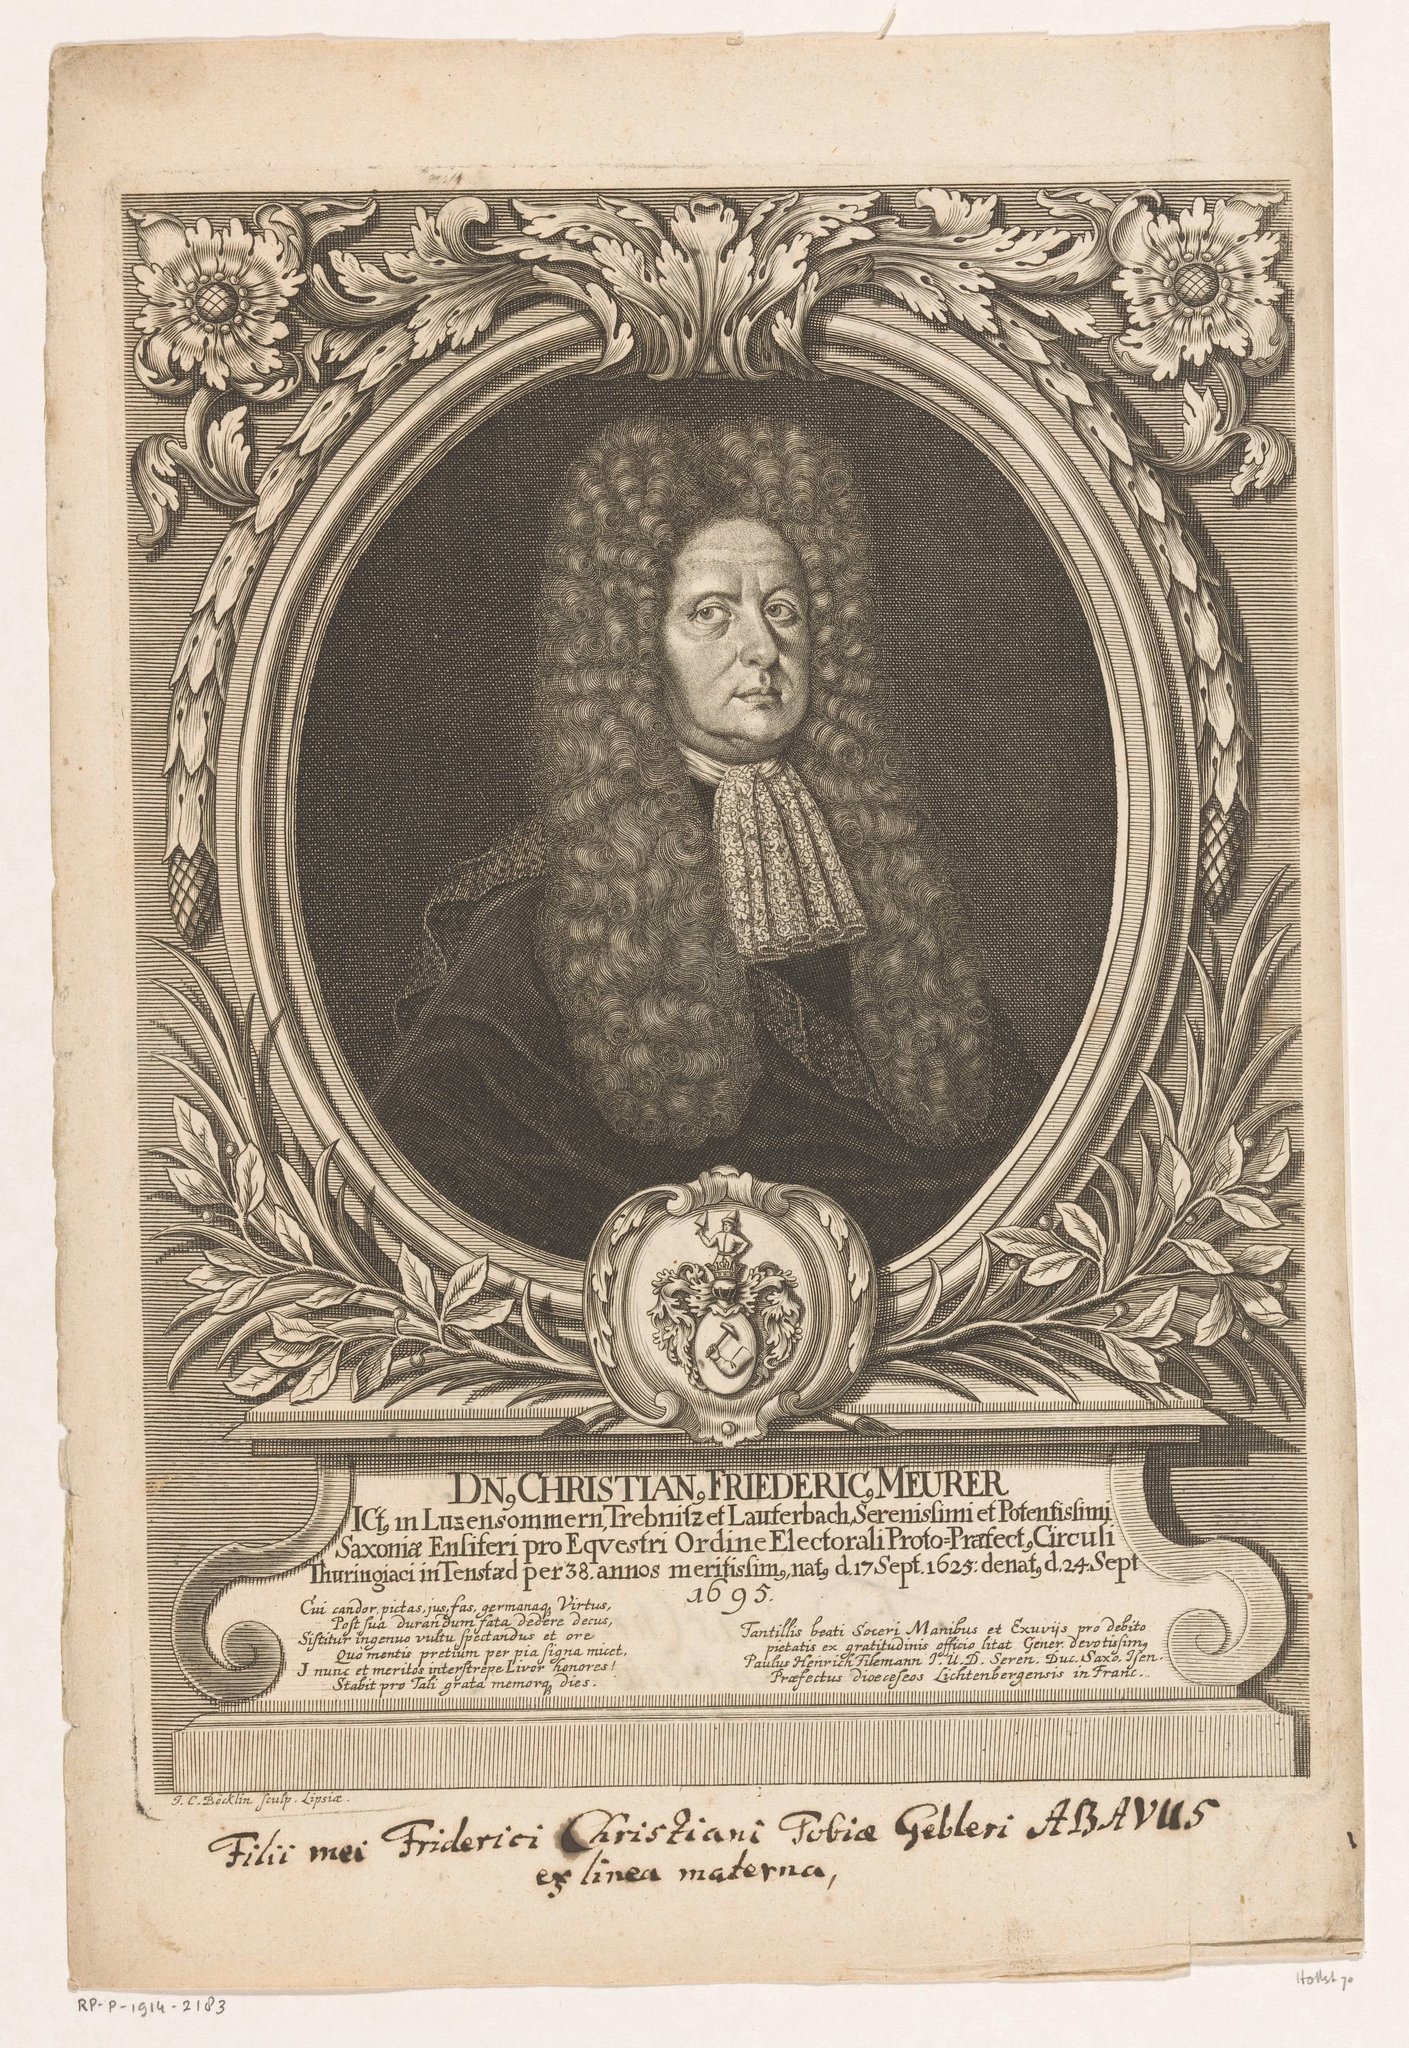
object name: print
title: Portret van Christian Friedrich Meurer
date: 1695-1709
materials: paper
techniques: engraving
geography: leipzig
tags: historical persons, armorial bearing, heraldry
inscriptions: inscription: ‘Filii mei Friderici Christiani Tobia Gebleri ABAVUS / ex linea materna’, inscription: ‘Stamboom beginnend bij de geportretteerde, Christanus Friedrich Meurer (1625-1695), tot aan Friedrich Christian Tobias Gebler (geboren 1741). Waarschijnlijk geschreven door de vader van de laatste.’, collector's mark: Lugt 2228